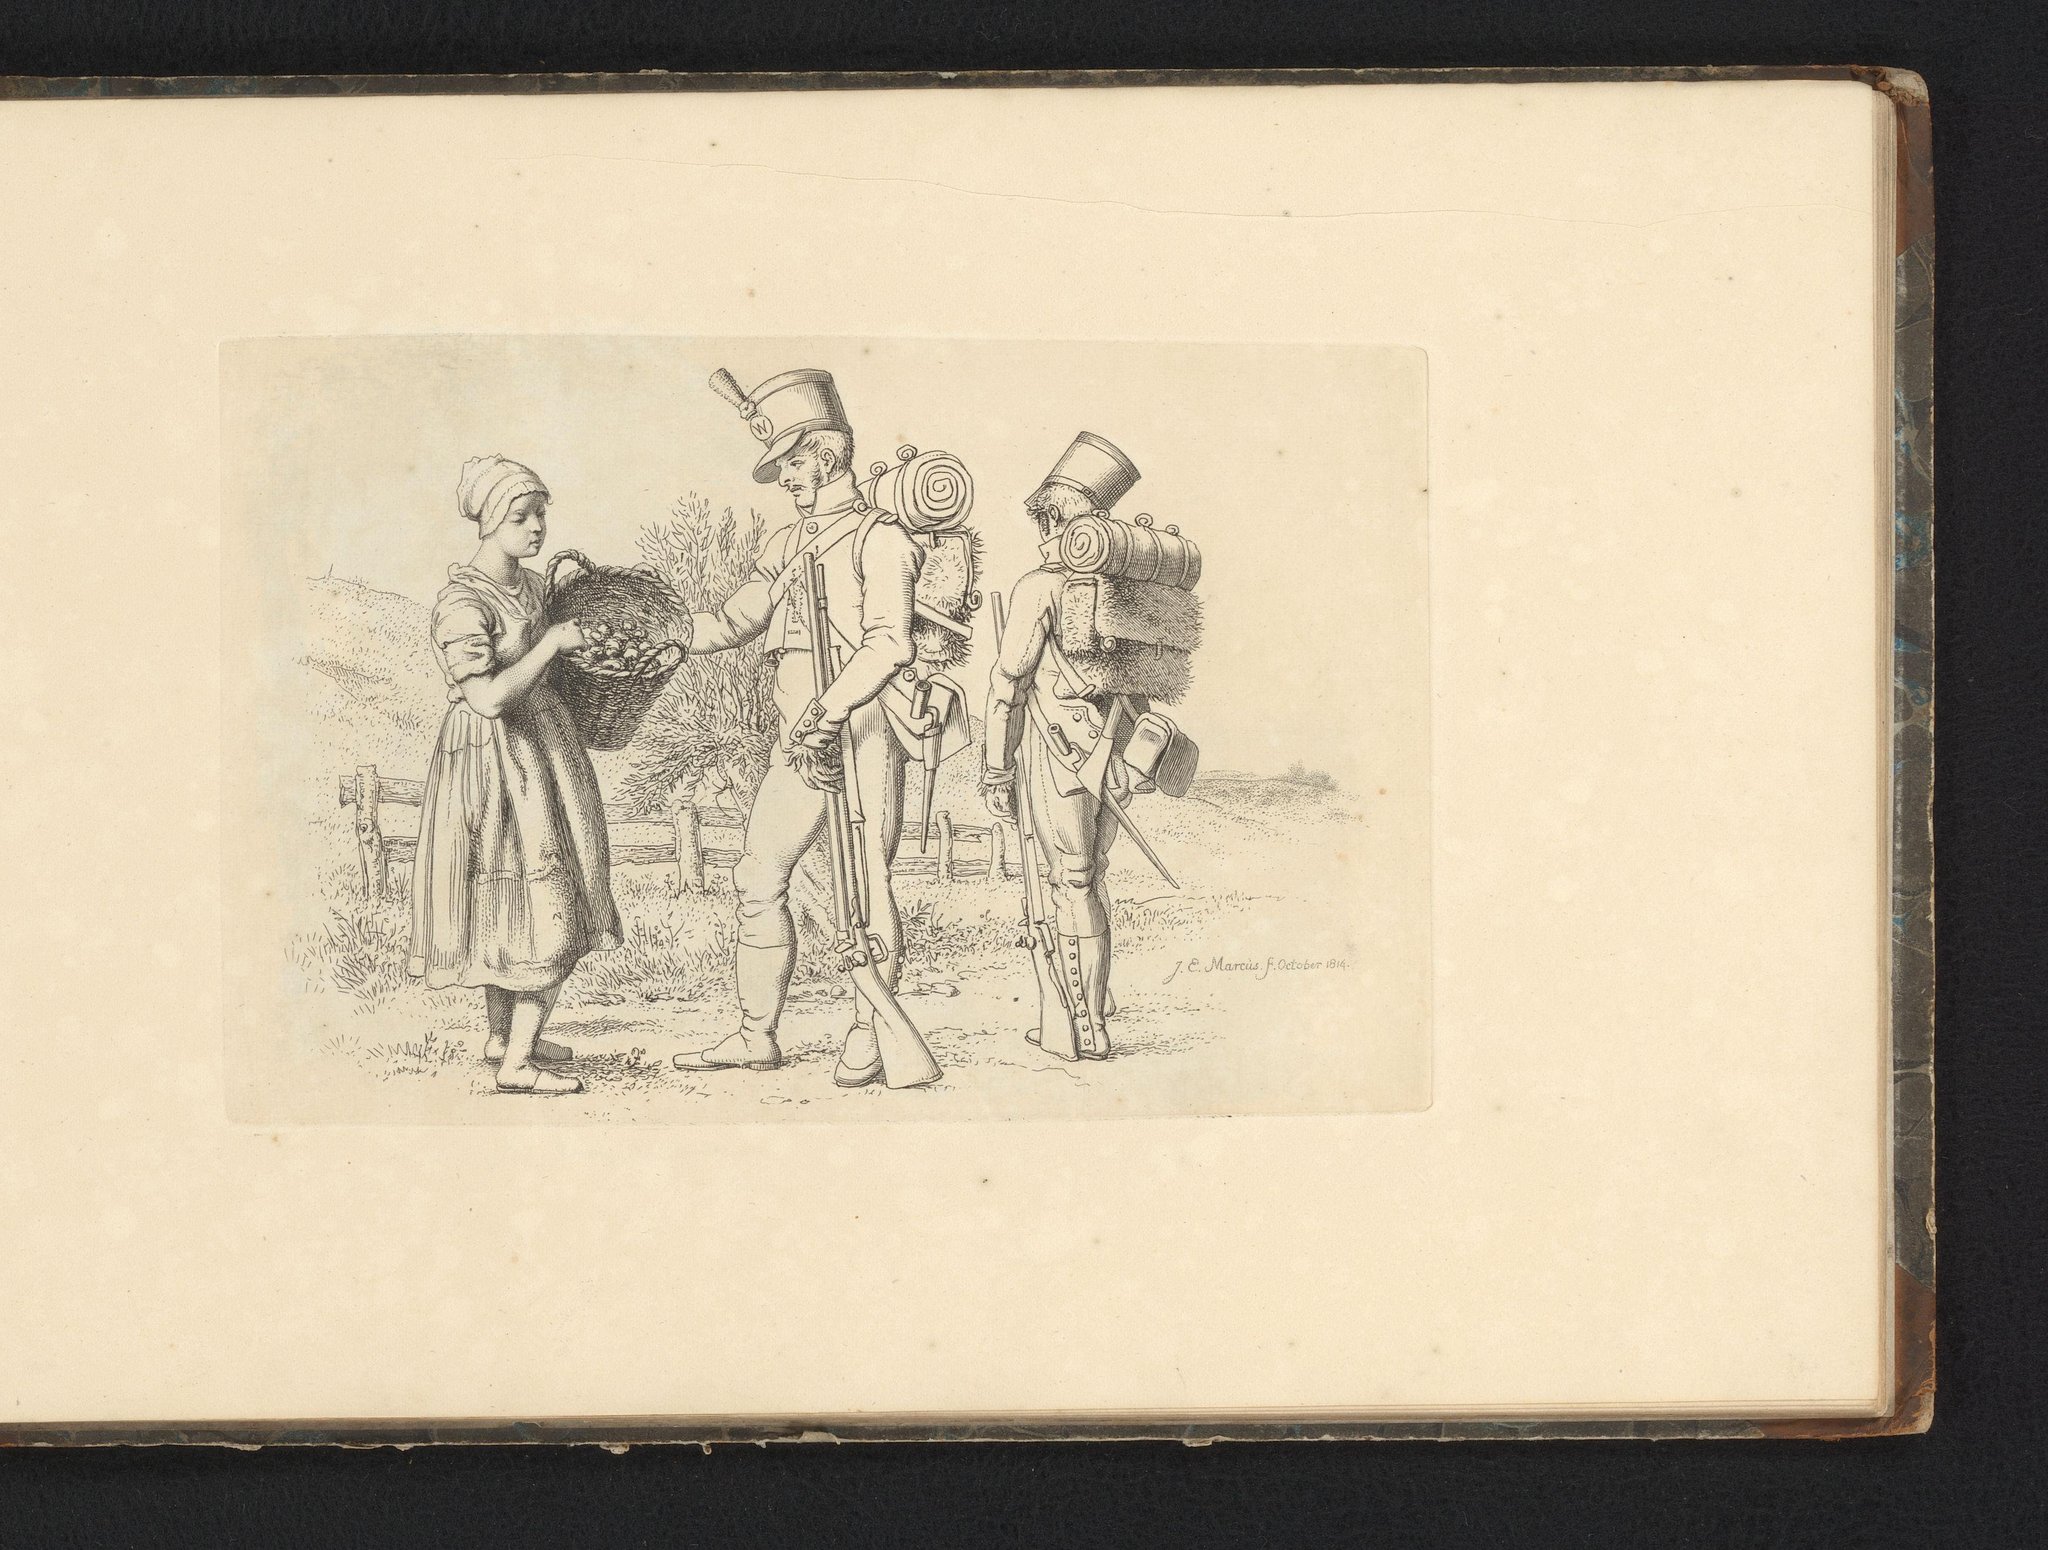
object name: print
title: Twee soldaten bij een jonge vrouw met fruitmand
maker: jacob ernst marcus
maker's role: draughtsman, print maker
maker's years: 1774-1826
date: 1810-1814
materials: paper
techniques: etching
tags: adolescent, young woman, maiden, private soldier, container made of plant material other than wood: basket, fruit harvest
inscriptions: date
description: Deze prent maakt deel uit van een album.